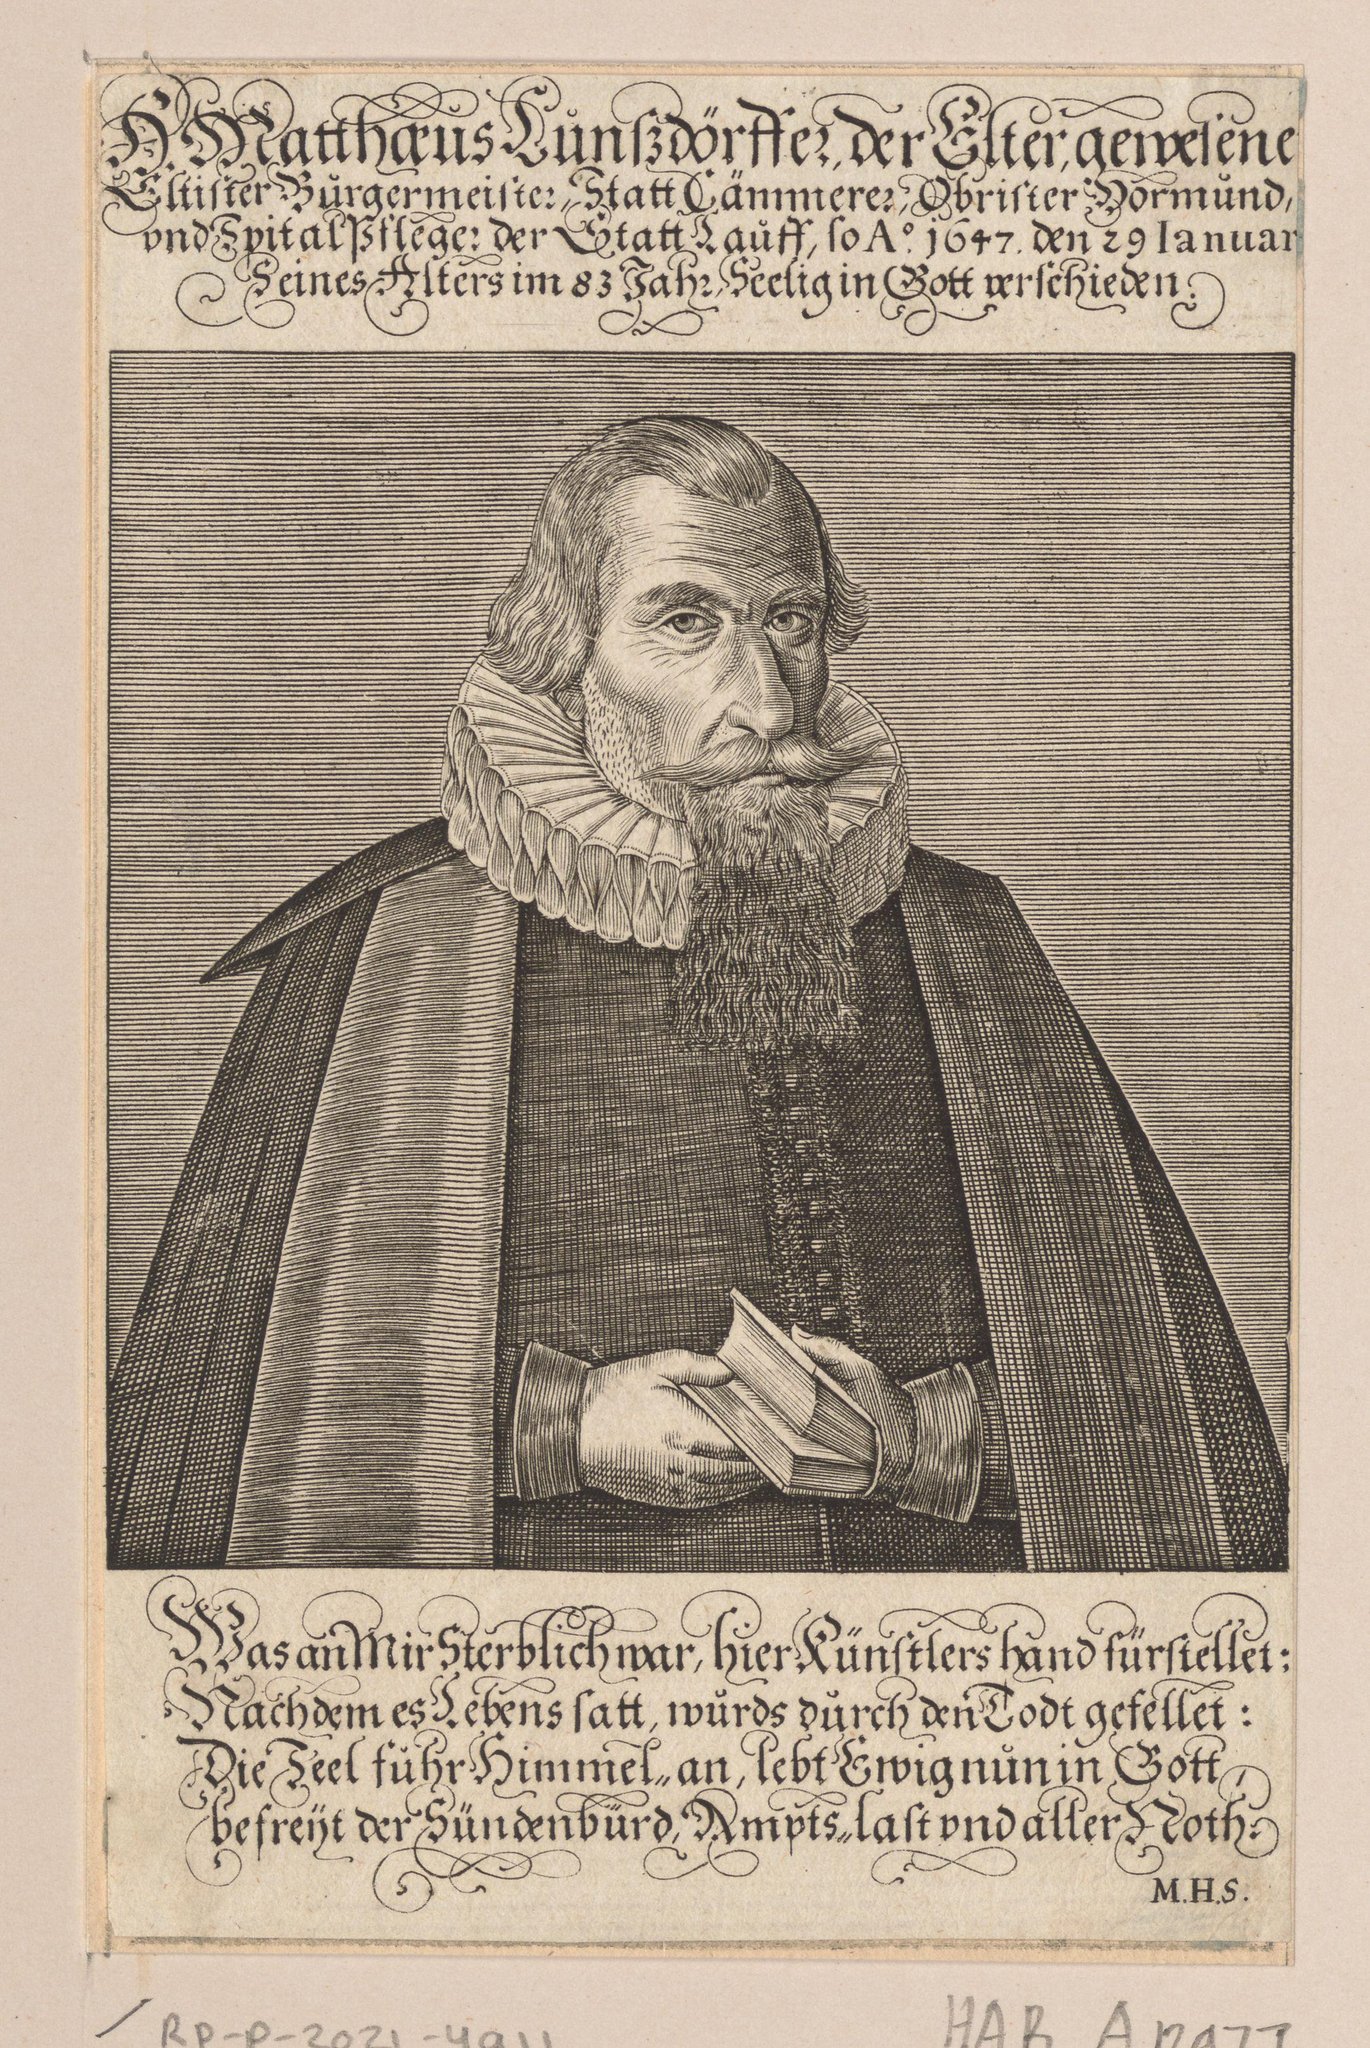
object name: print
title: Portret van Matthäus Lunssdörffer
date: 1647-1660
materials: paper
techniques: engraving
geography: germany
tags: historical persons, book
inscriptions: number: ‘N 15886’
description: Met boven het portret biografische gegevens en onder het portret een vierregelig vers in het Duits.